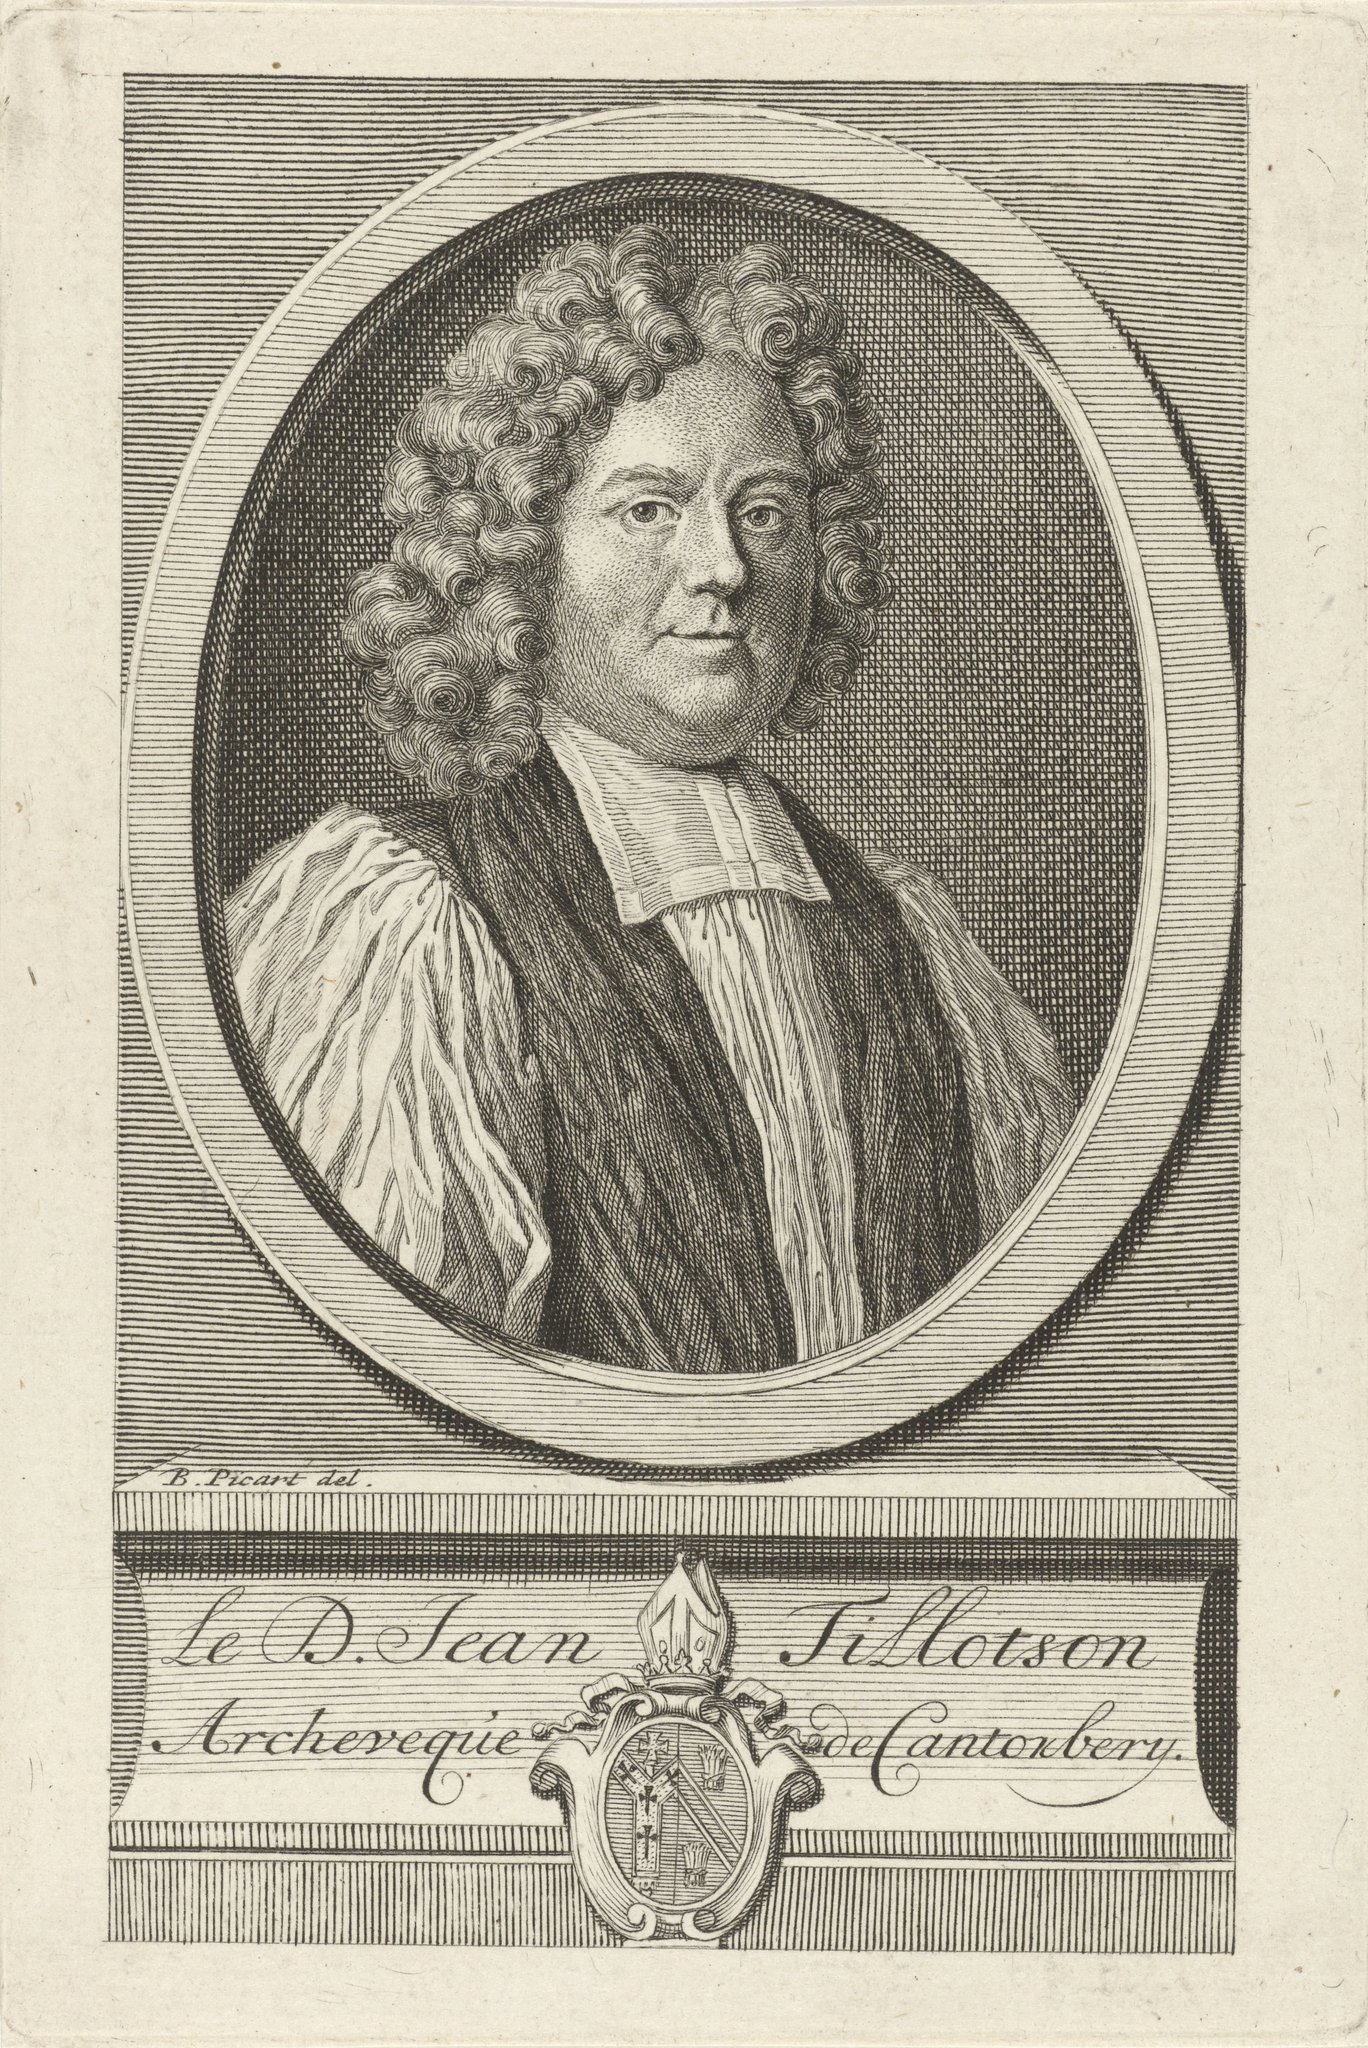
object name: print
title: Portret van John Tillotson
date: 1683-1733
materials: paper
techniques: engraving, etching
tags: clergyman, armorial bearing, heraldry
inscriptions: collector's mark: Lugt 2228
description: Portret van John Tillotson, aartsbisschop van Canterbury. Op de piëdestal zijn wapenschild.